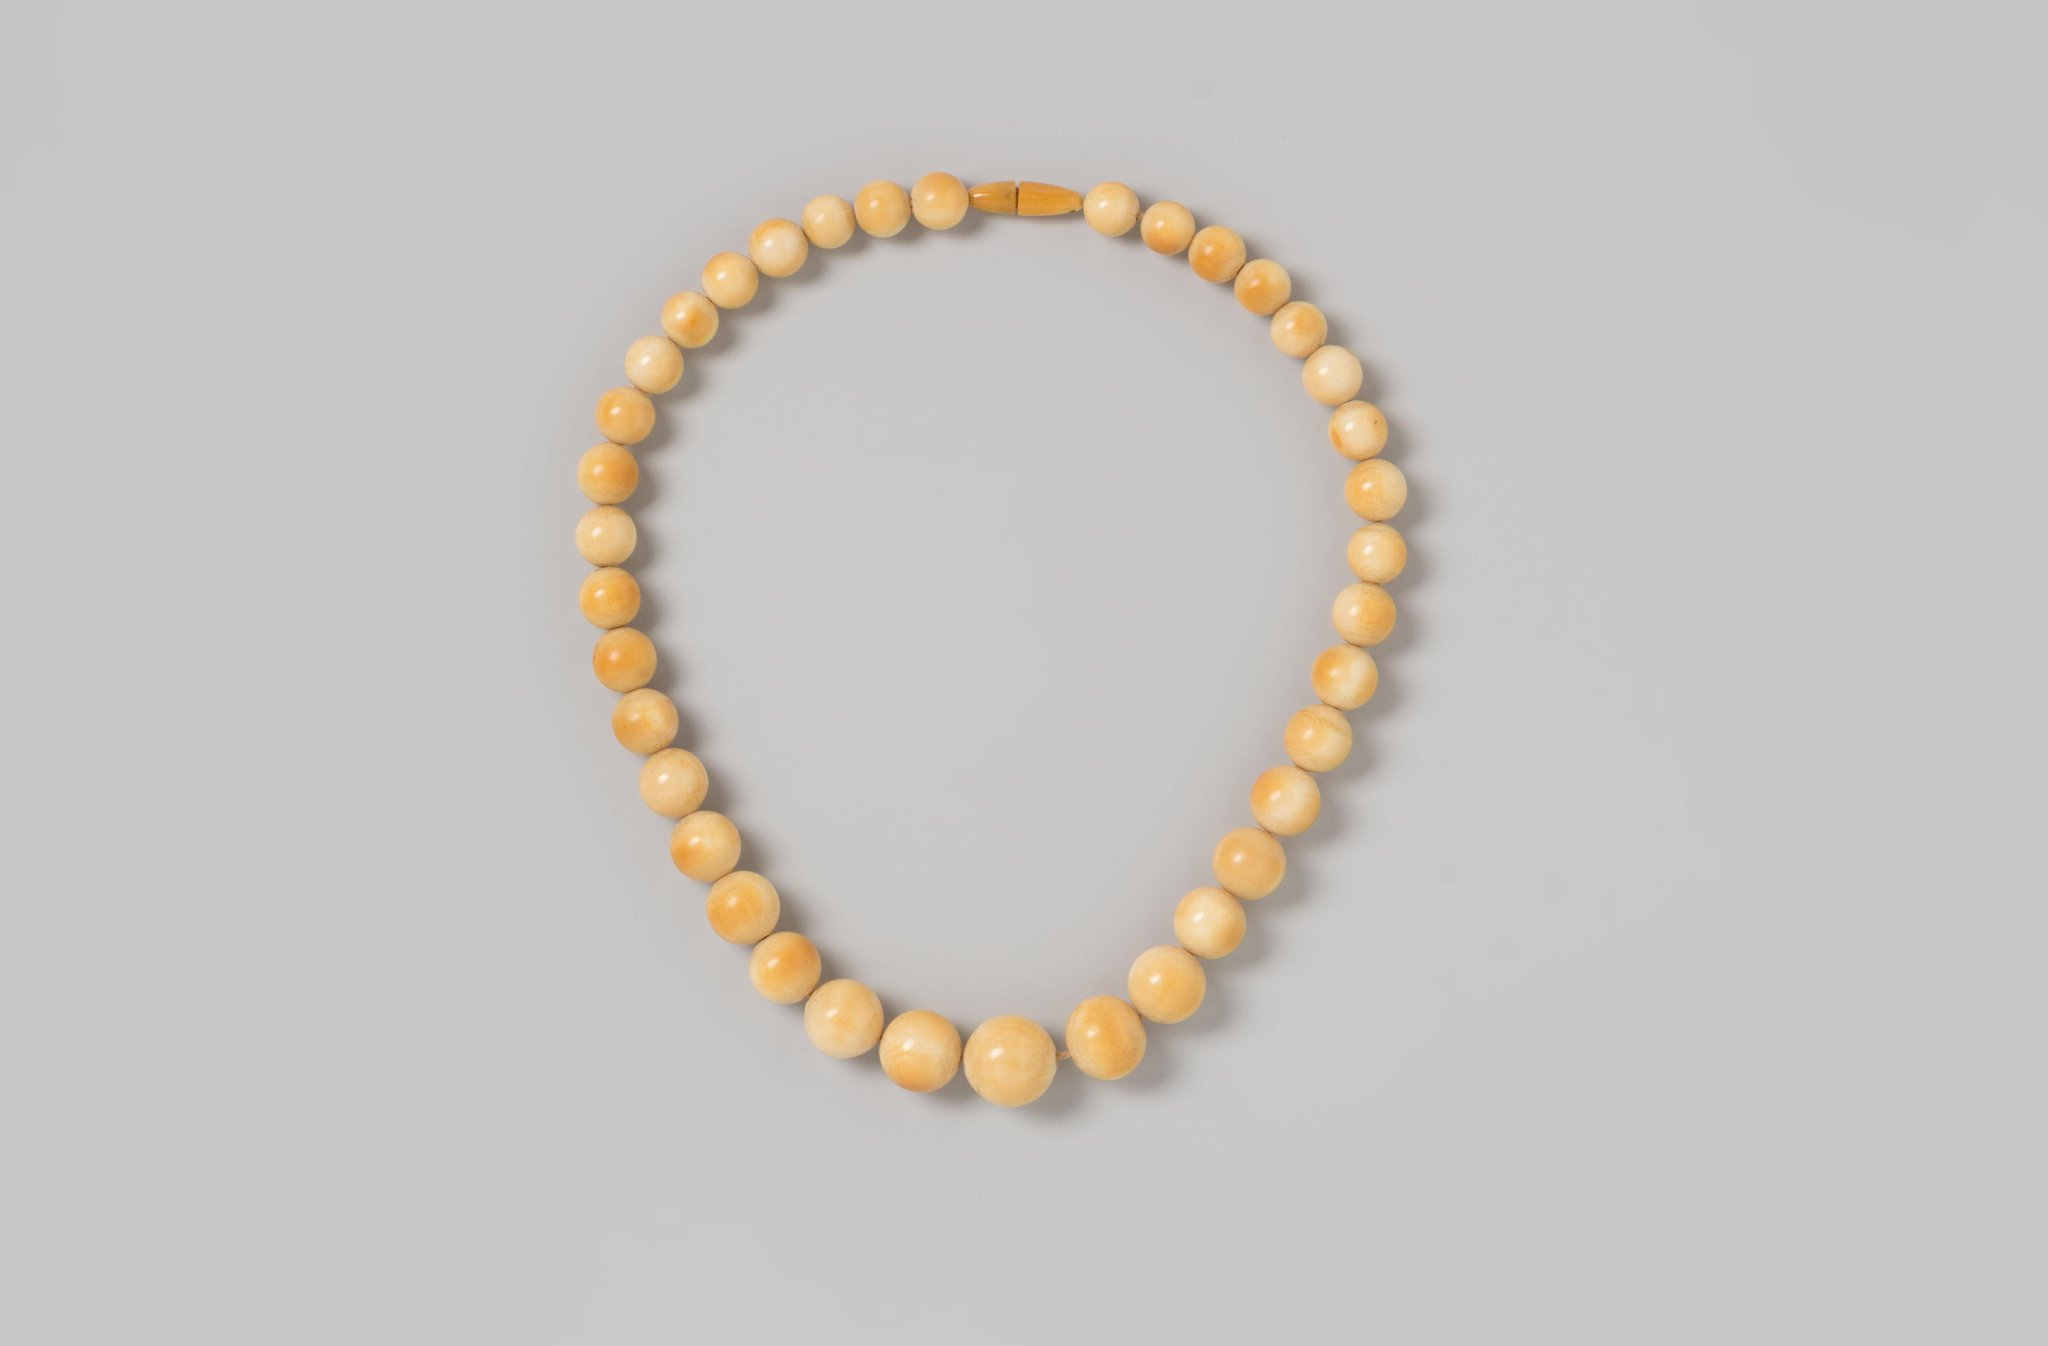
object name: chain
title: Ketting van ivoren kralen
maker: Anonymous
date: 1920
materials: ivory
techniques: sewing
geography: western europe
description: Ketting van ivoren kralen. Art déco. De bolronde kralen zijn van afwisselende grootte; met een schroefslot.